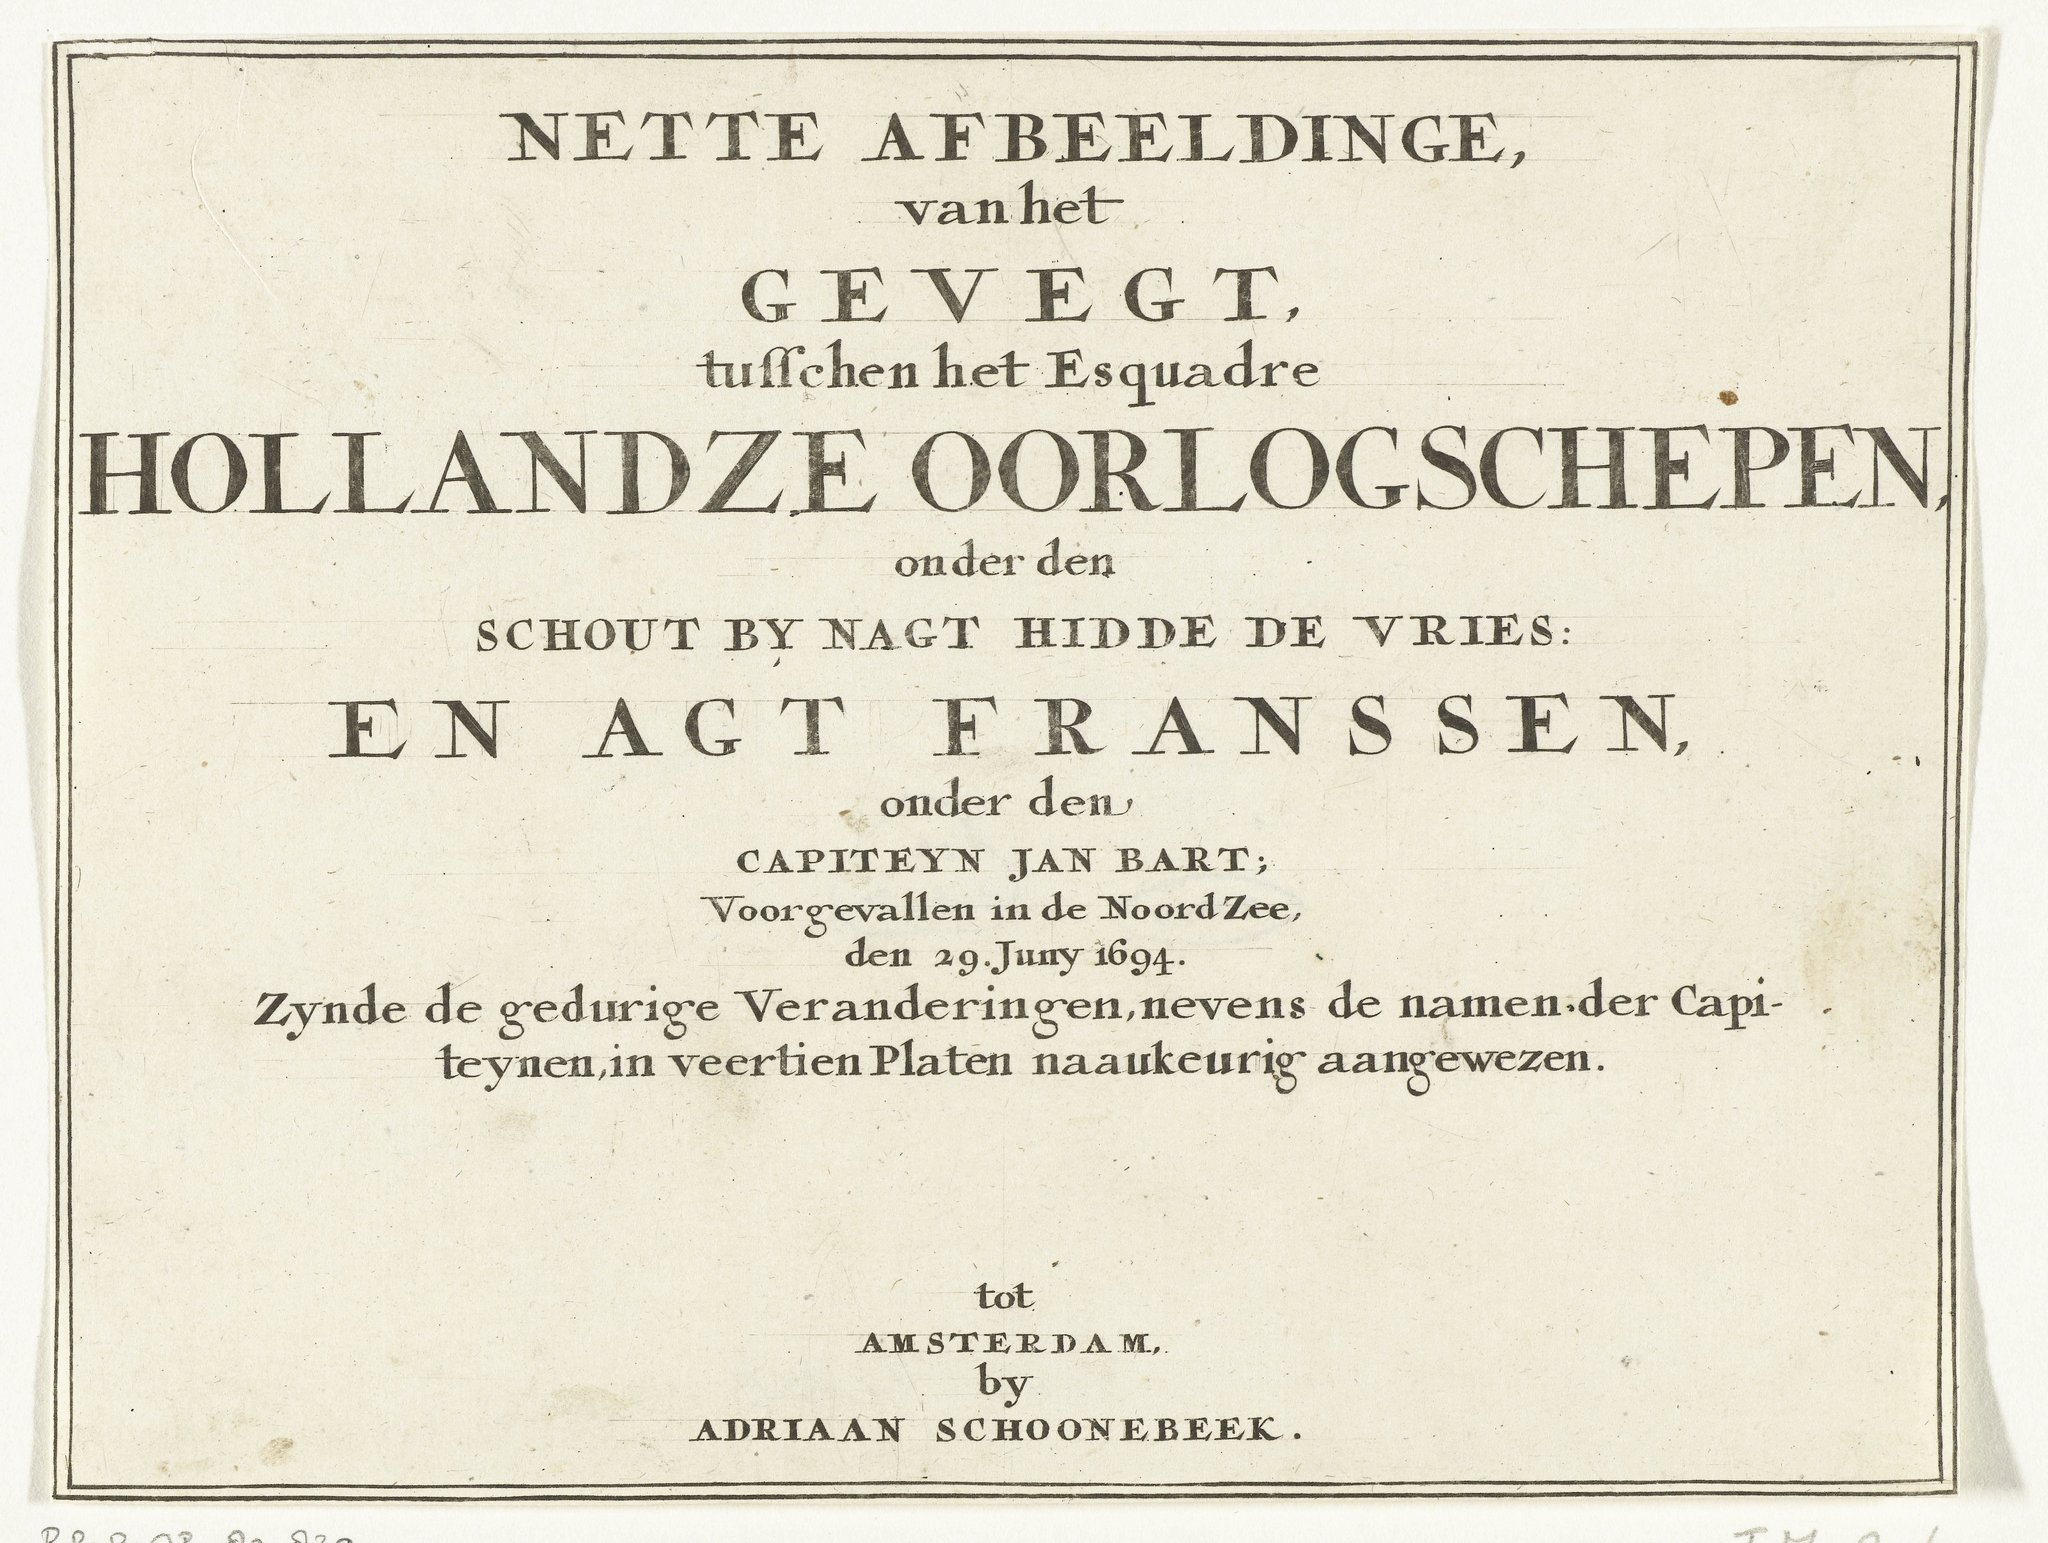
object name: titelprent, frontispice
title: Nette Afbeeldinge, van het Gevegt tusschen het Esquadre Hollandze Oorlogschepen, onder den schout by nagt Hidde de Vries: en Agt Franssen, onder den capiteyn Jan Bart; voorgevallen in de Noord Zee, den 29. Juny 1694. Zynde de gedurige Veranderingen, nevens de namen der Capiteynen, in veertien Platen naaukeurig aangewezen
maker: adriaen schoonebeek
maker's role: print maker, publisher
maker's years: 1661-1705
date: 1694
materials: paper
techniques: etching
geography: amsterdam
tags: sexbierum, schout-bij-nacht, hidde sjoerds de vries, duinkerke, kapitein-ter-zee, jan bart, negenjarige oorlog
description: Titelprent voor een serie van 14 genummerde platen van een zeegevecht voorgevallen tussen een Hollands eskader onder Hidde Sjoerds de Vries en Franse schepen onder Jan Bart op de Noordzee, 29 juni 1694.